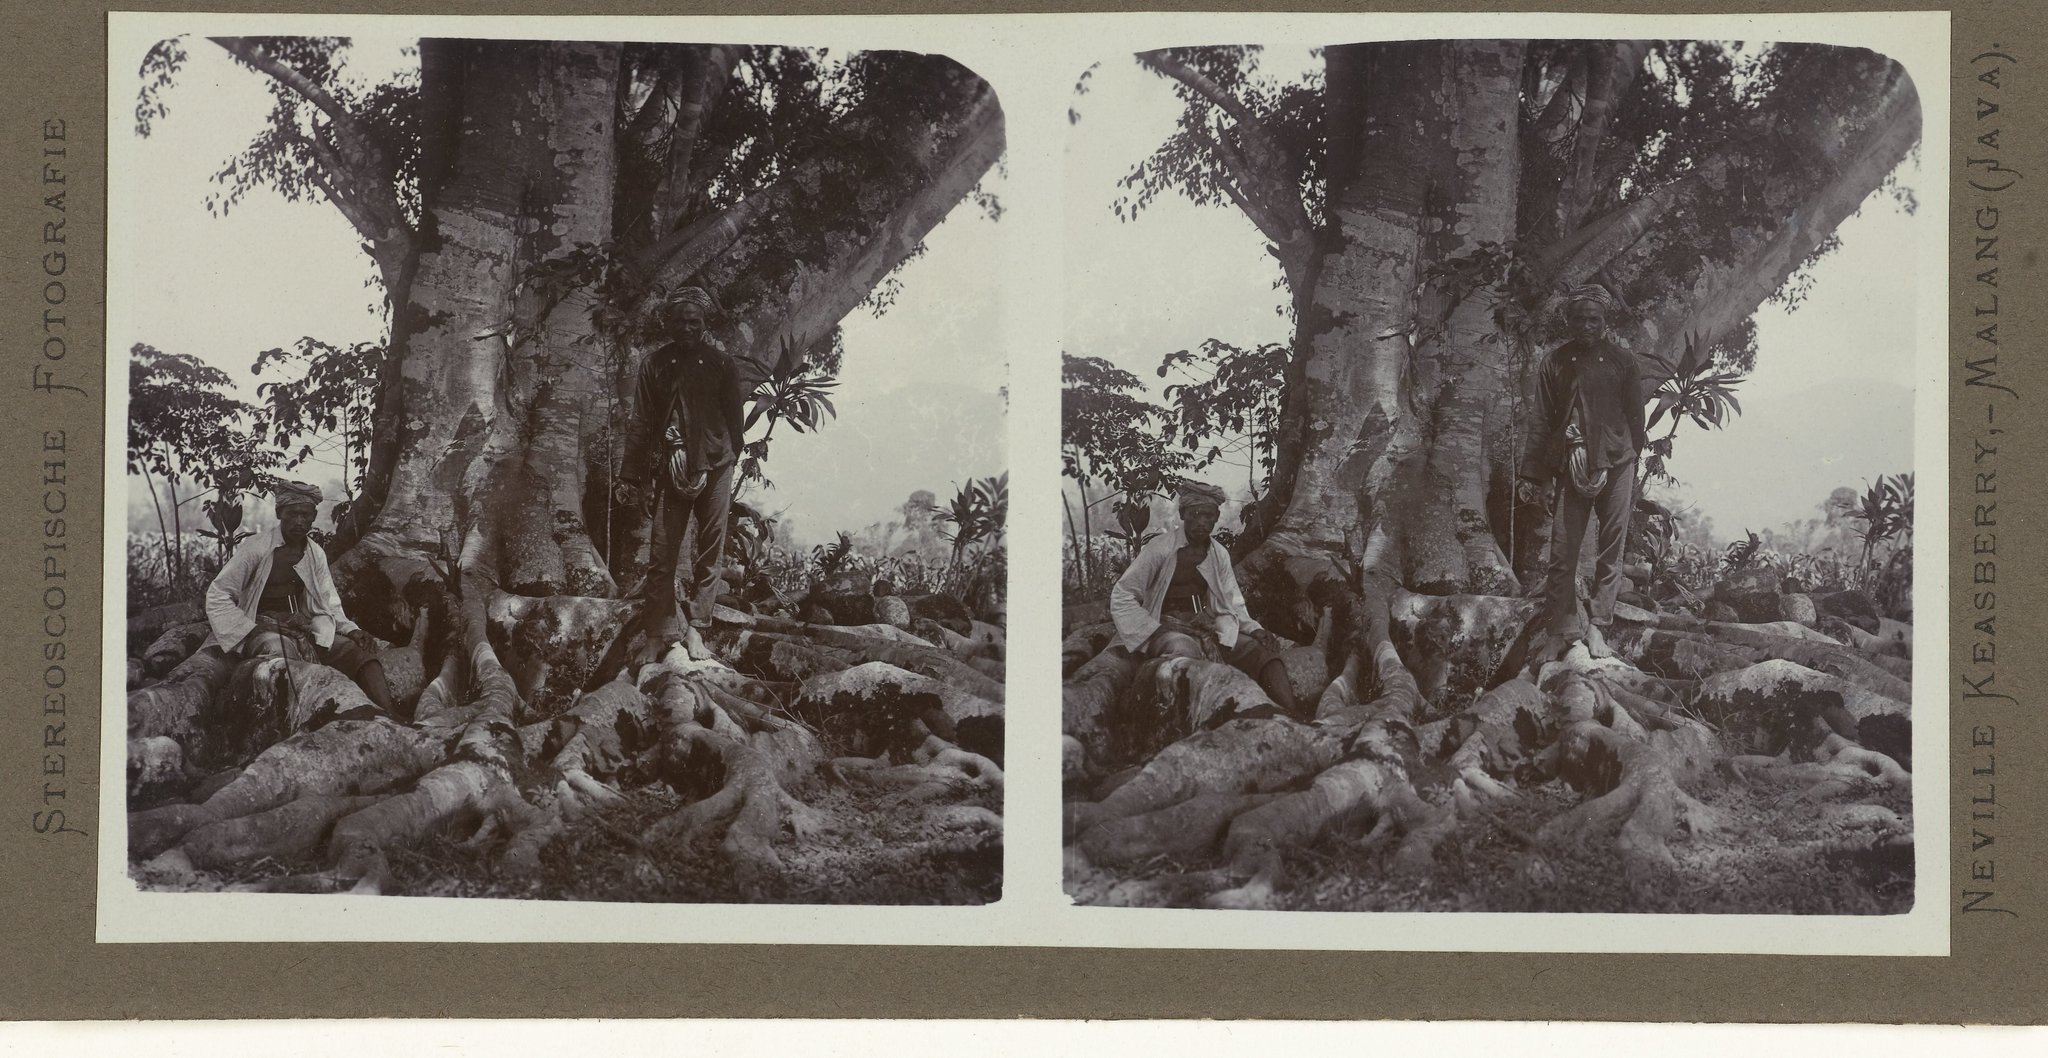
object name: stereograph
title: Twee mannen onder een grote Waringinboom.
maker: neville keasberry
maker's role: fotograaf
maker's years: 1866-1944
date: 1900-1935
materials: cardboard, paper, photographic support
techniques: albumen print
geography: malang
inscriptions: signature: ‘Neville Keasberry, Malang (Java)’, inscription: ‘Stereoscopische Fotografie’